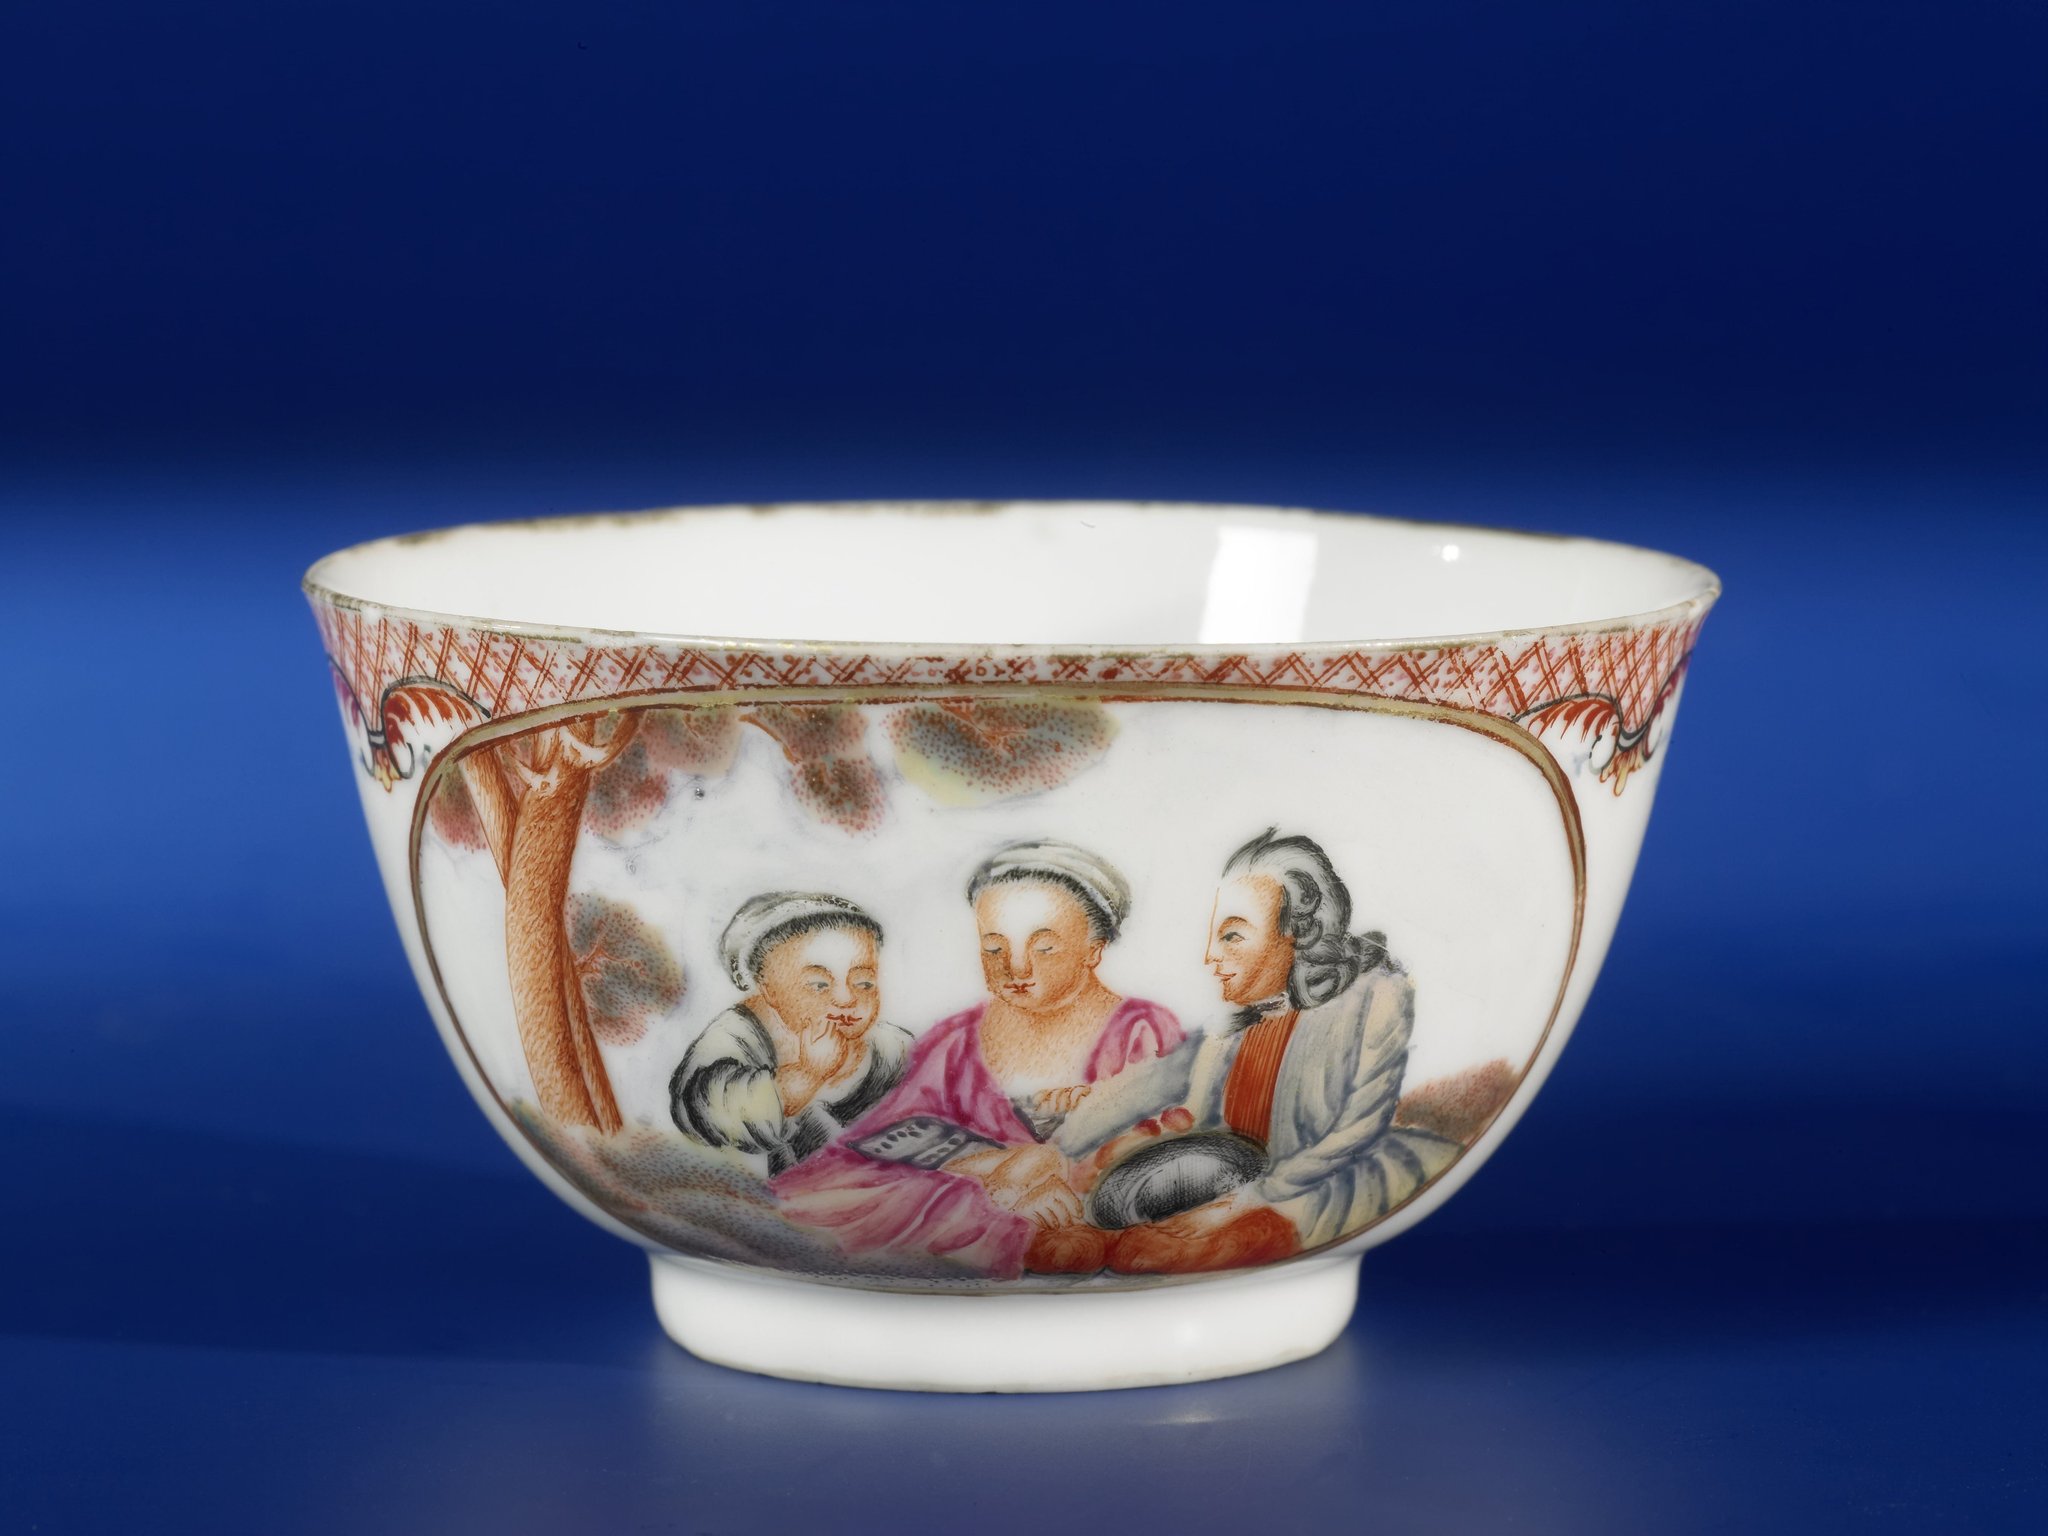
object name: cup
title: Bell-shaped cup with Eurpean people in a landscape in oval medallions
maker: Anonymous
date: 1750-1774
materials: glaze, gold, paint, porcelain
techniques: firing, gilding, turning, vitrification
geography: china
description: Wijd uitlopende theekom op een hoge voetring. Gedecoreerd in emailkleuren met een havengezicht. Op de rand een ruitpatroon. Binnen een cartouche zijn twee mannen afgebeeld, zij kijken naar een paar schepen verder op de achtergrond. Verder nog een paar huizen op de achtergrond. Binnen de tweede cartouche zijn een dame en een heer afgebeeld, vergezeld door een chaperonne. De voorstelling werd vervaardigd naar een prent van Claude Duflos (1665-1727).